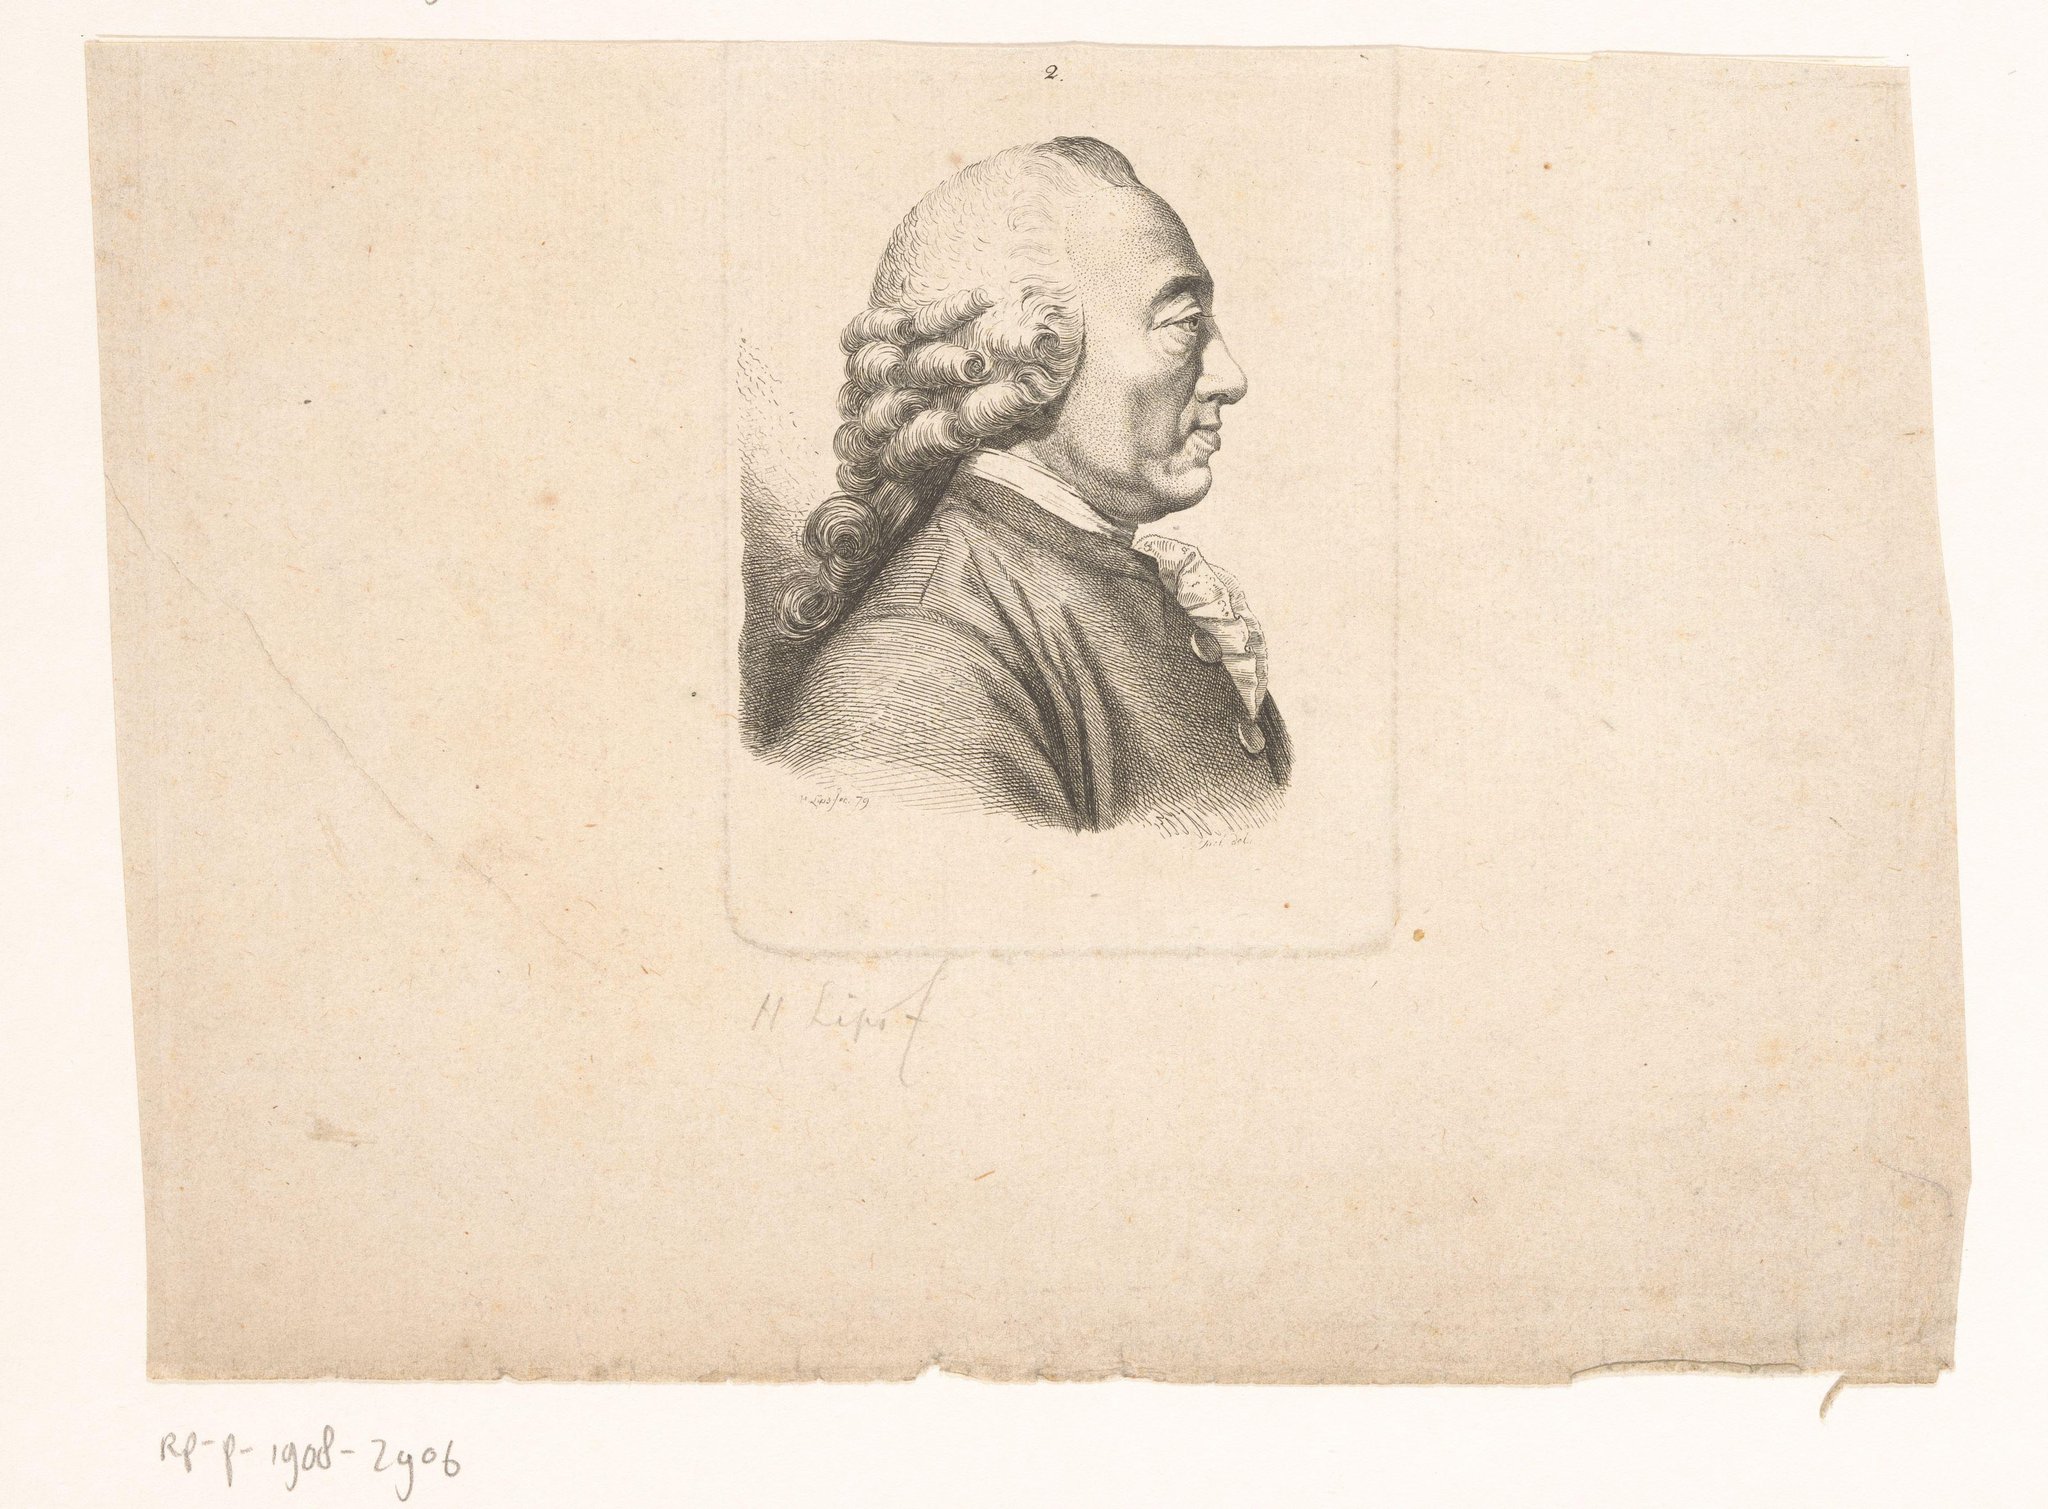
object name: print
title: Portret van een onbekende man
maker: johann heinrich lips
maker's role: draughtsman, painter, print maker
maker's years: 1758-1817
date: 1779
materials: paper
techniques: etching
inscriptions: collector's mark: Lugt 2228